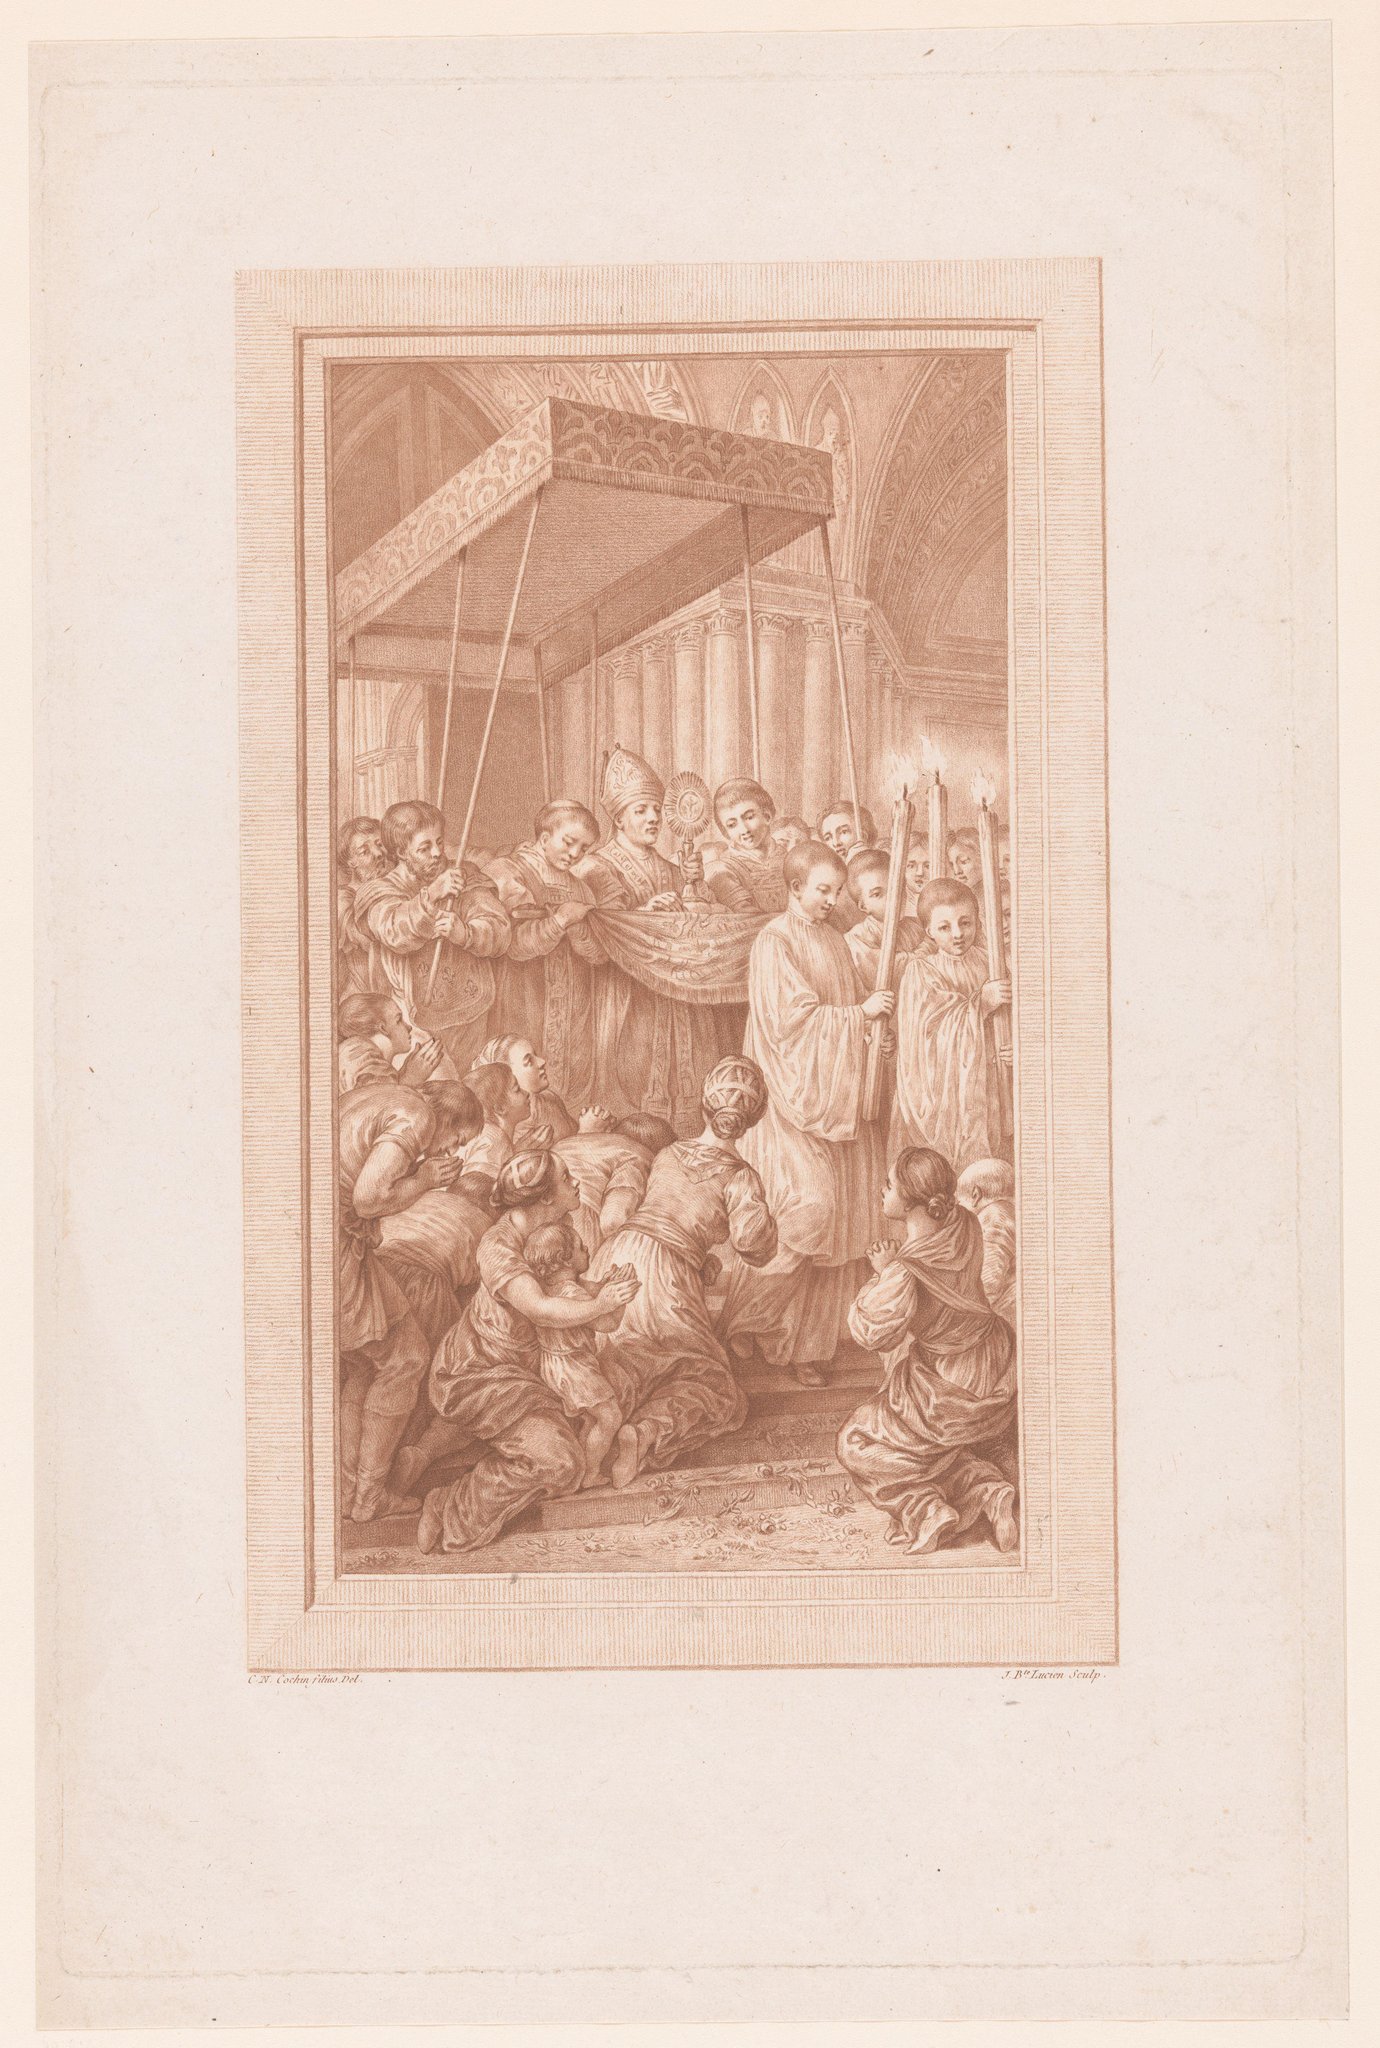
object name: print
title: Processie met monstrans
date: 1758-1806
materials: paper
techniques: printmaking, etching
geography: france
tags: ostensorium, monstrance, procession ~ christian religion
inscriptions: collector's mark: Lugt 2228